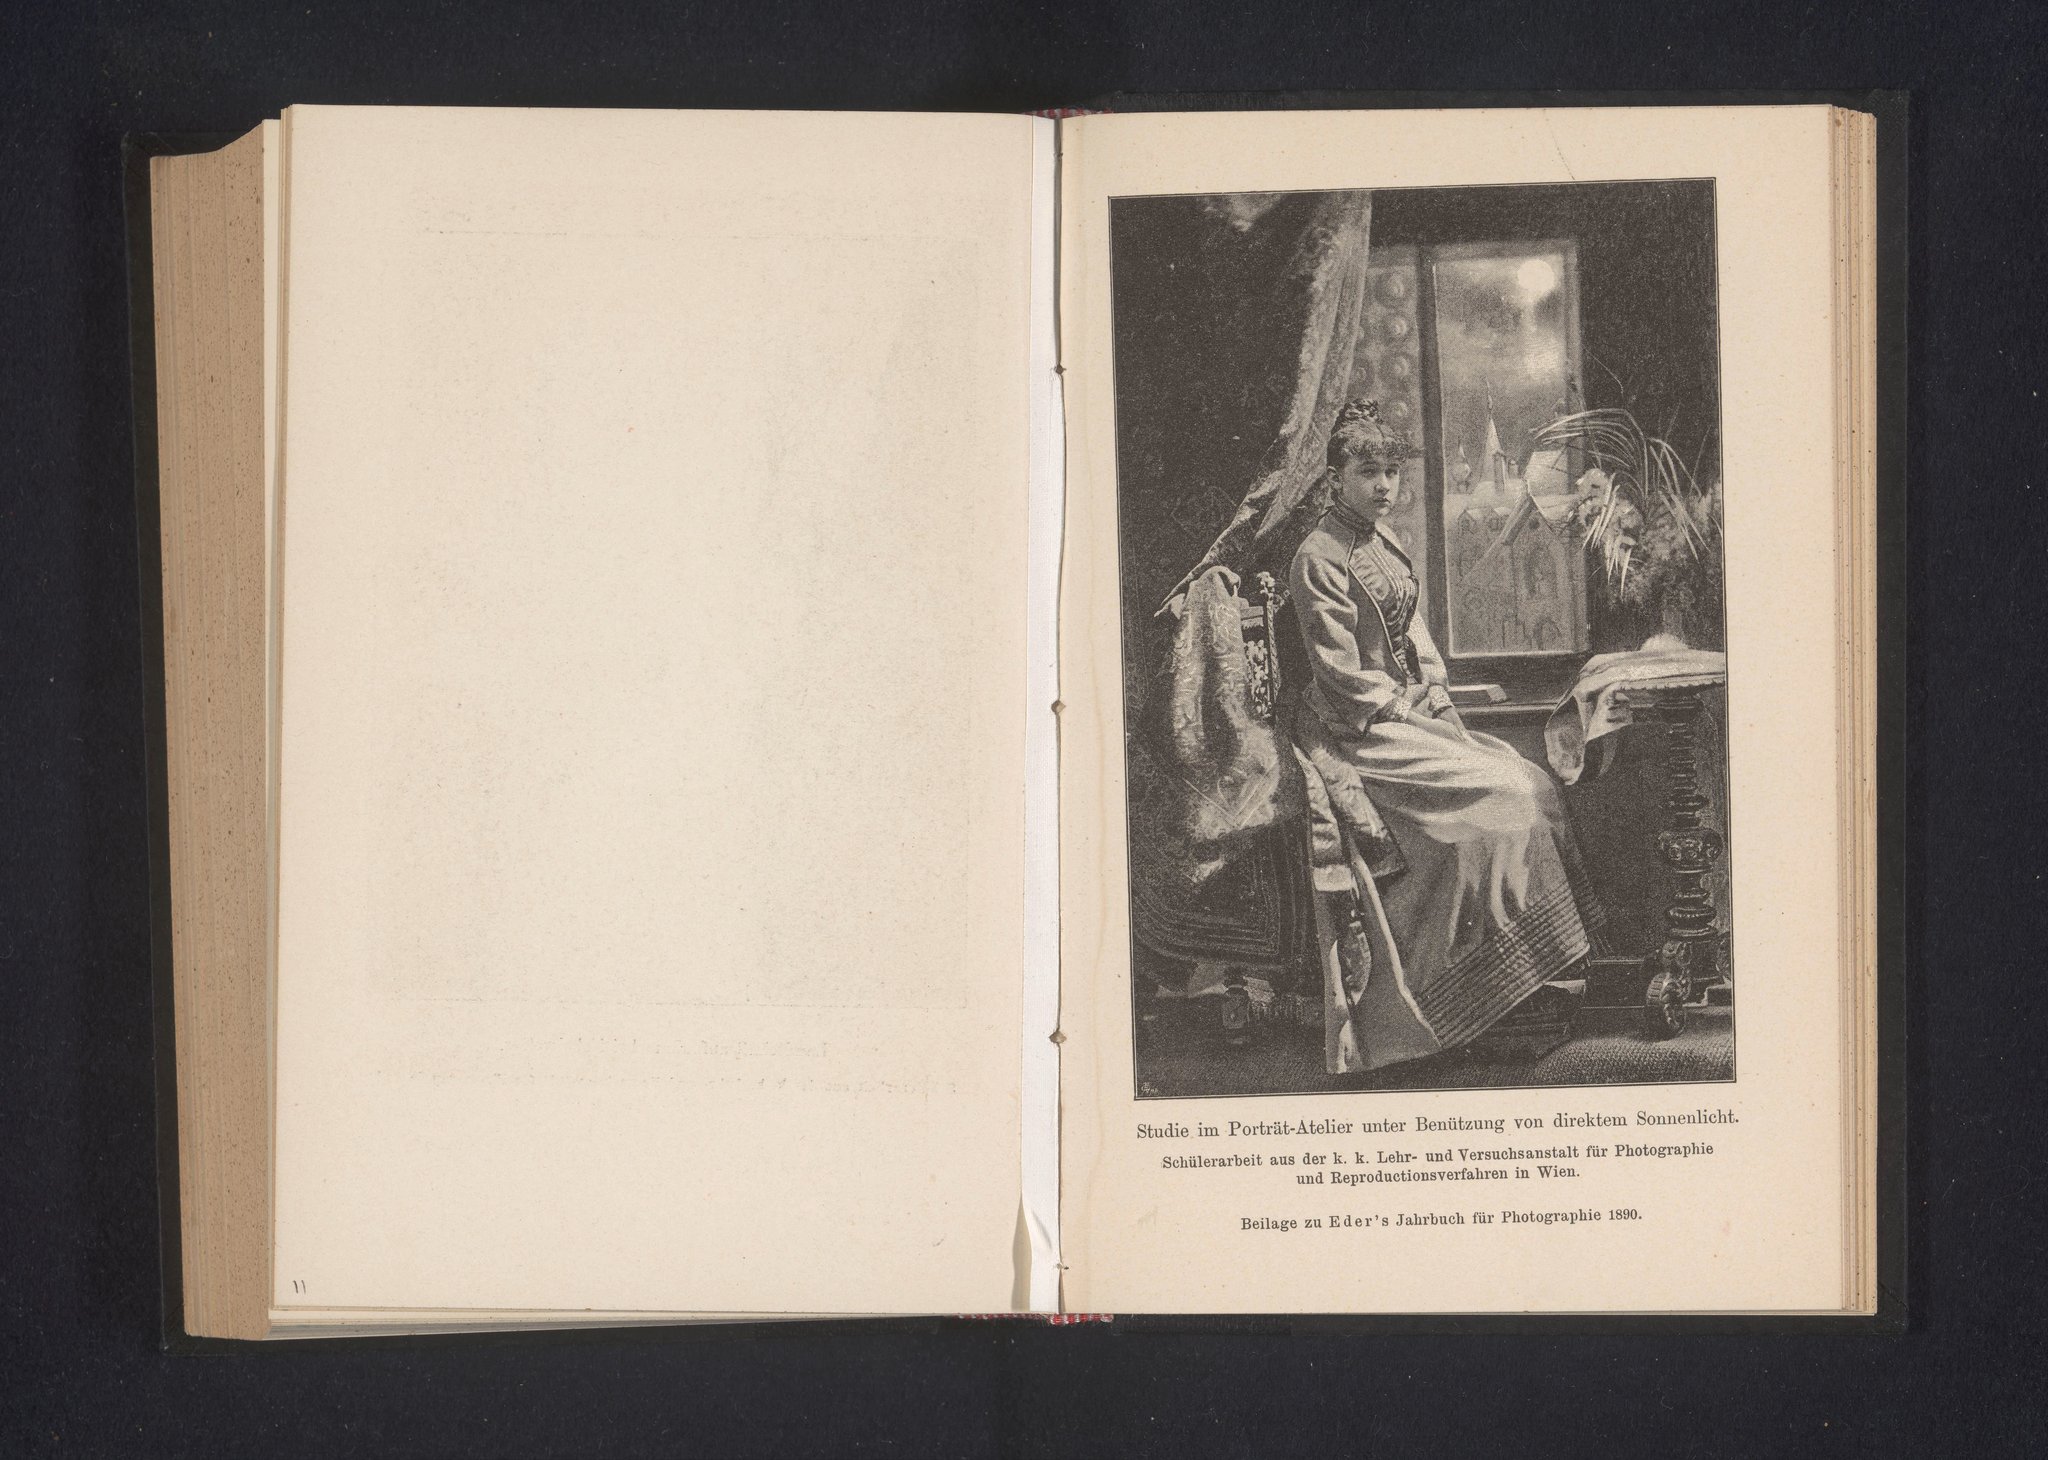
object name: photomechanical print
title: Studioportret van een onbekende vrouw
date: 1885-1890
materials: paper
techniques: autotype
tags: historical persons - bb - woman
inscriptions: monogram: ‘AC’, inscription: ‘Studie im Porträt-Atelier unter Benützung von direktem Sonnenlicht./ Beilage zu Eder's Jahbruch für Photographie 1890’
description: Prent op vijfentwintigste ongenummerde pagina na pagina 400.